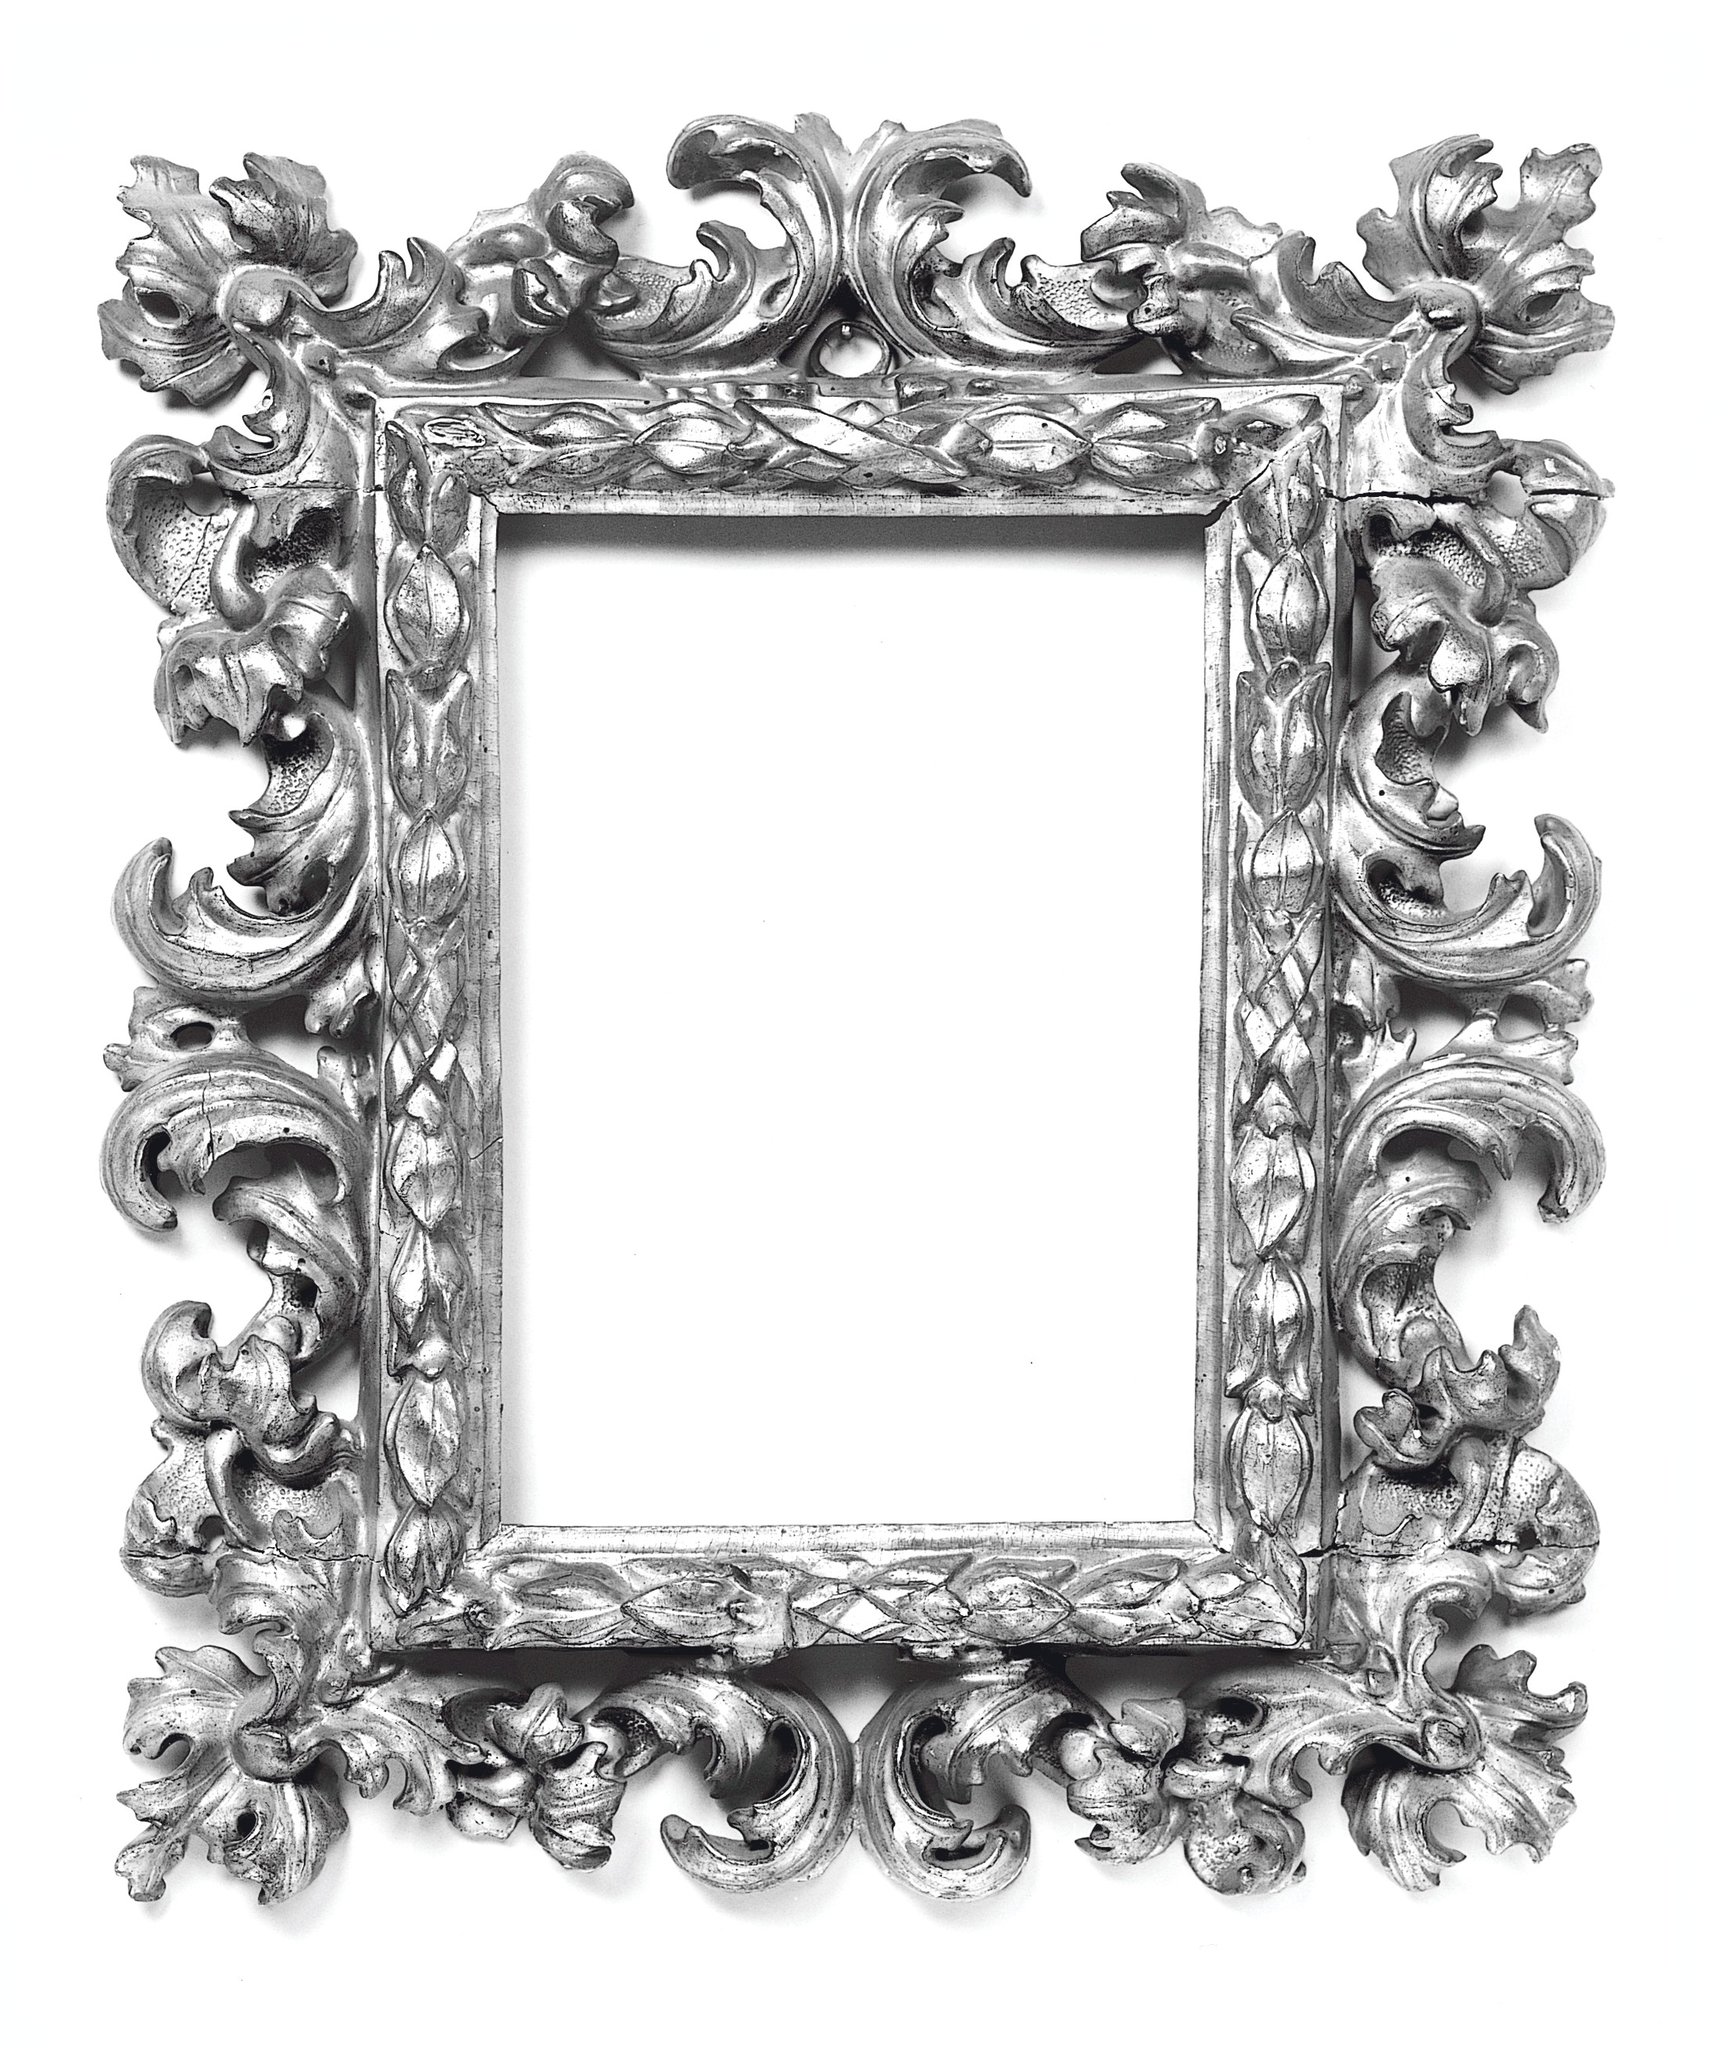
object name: frame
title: Pierced acanthus-leaf frame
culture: italian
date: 1640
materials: wood